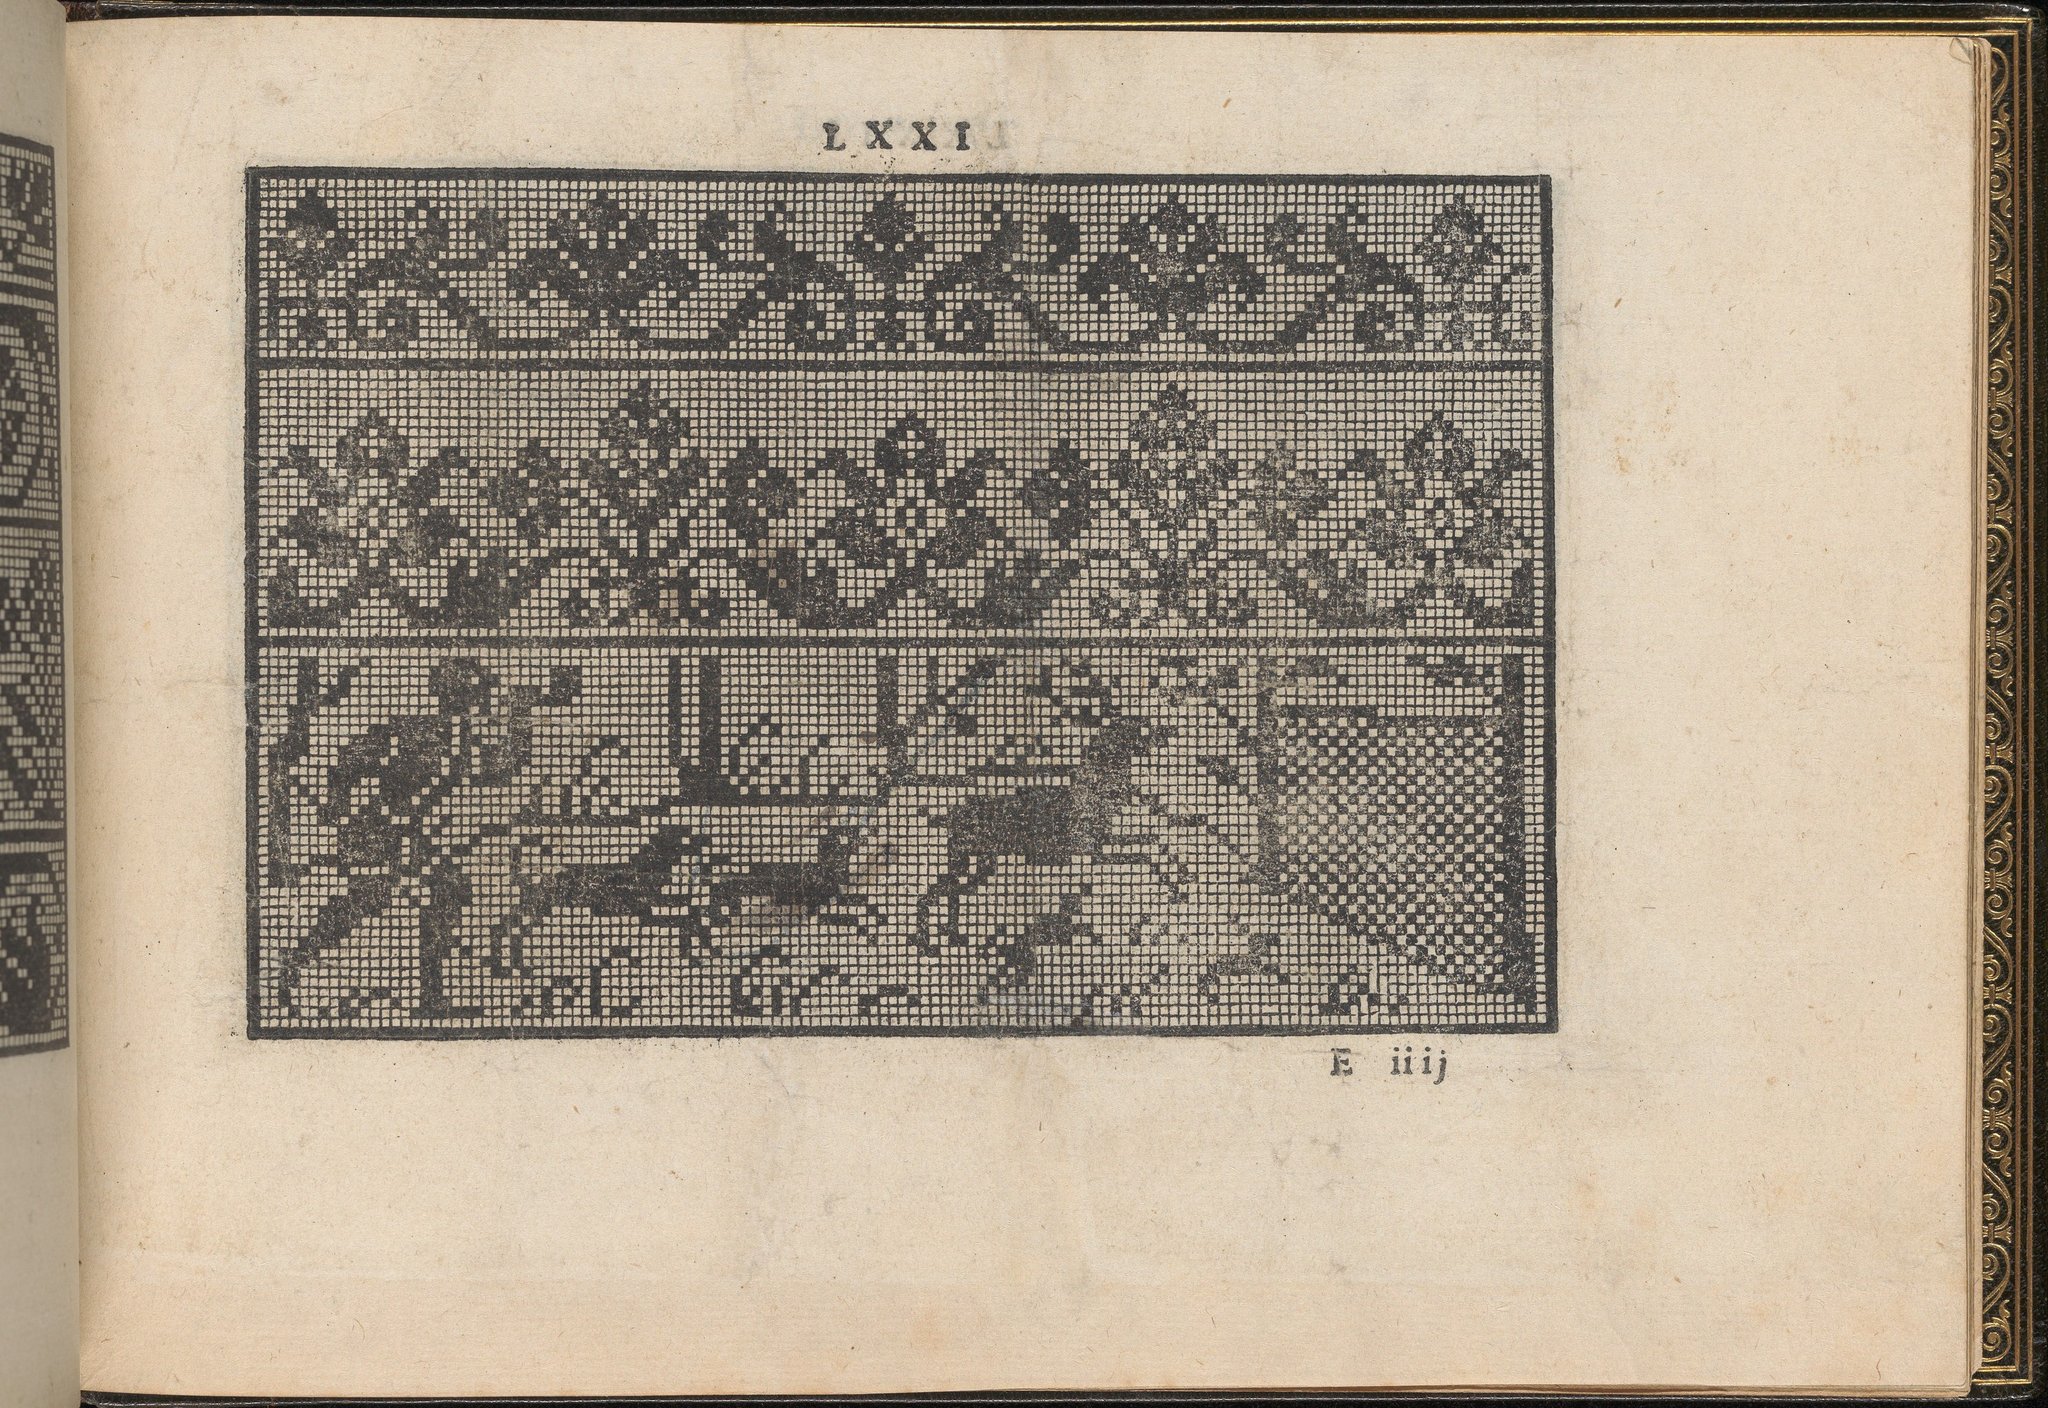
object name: book print ornament architecture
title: La Vera Perfettione del Disegno di varie sorti di recami, page 36 (recto)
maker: giovanni ostaus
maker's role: publisher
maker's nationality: italian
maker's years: 1507-1607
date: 1567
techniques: woodcut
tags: fences,men,hunting,deer,dogs,rabbits,flowers